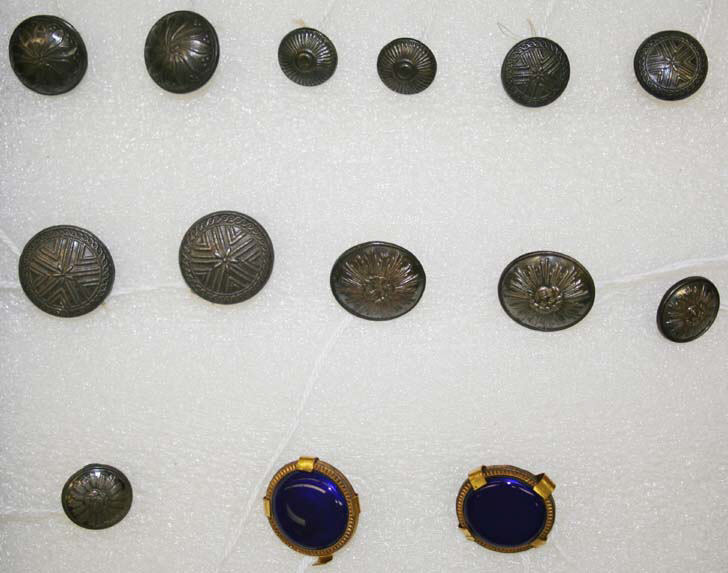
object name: button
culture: french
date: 1775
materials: bone, metal, wood